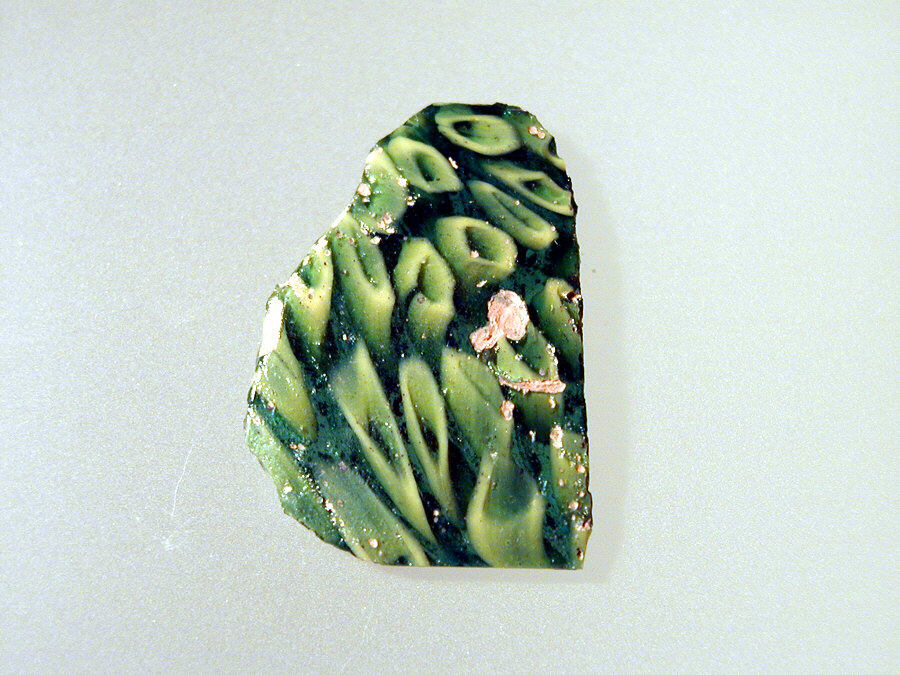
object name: fragment, mosaic bowl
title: Glass mosaic bowl fragment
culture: roman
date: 34 BCE-33 CE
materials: glass